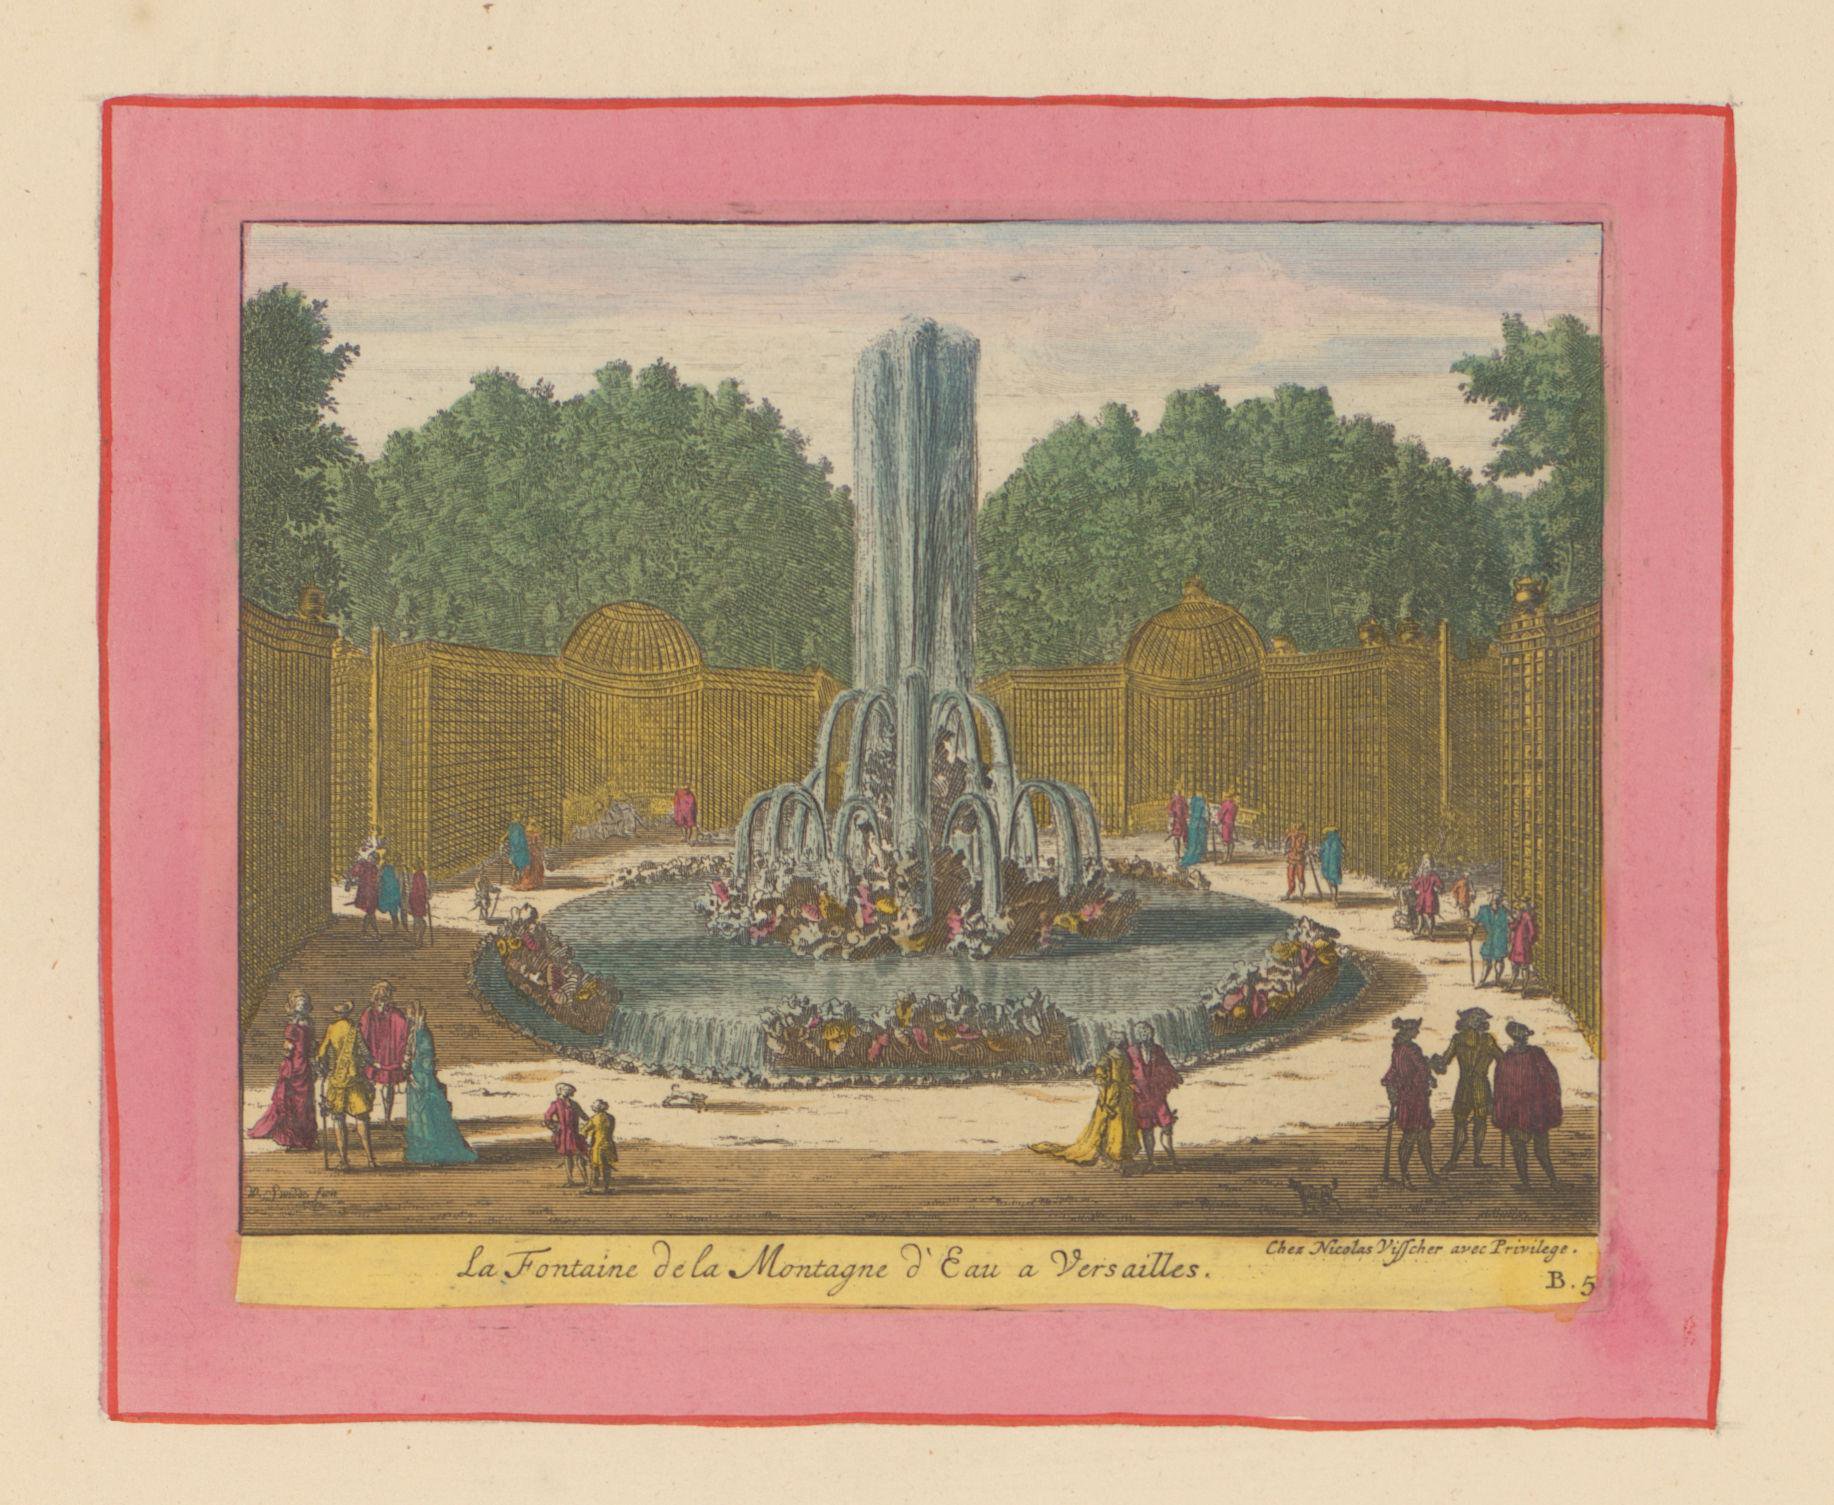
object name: print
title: Veues de Versailles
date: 1686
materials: paper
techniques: etching, hand coloring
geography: the hague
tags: garden fountain, french or architectonic garden; formal garden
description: De prent maakt deel uit van een serie bestaande uit 87 genummerde prenten (volgens Hollstein). De serie is opgedeeld in de delen A t/m F.